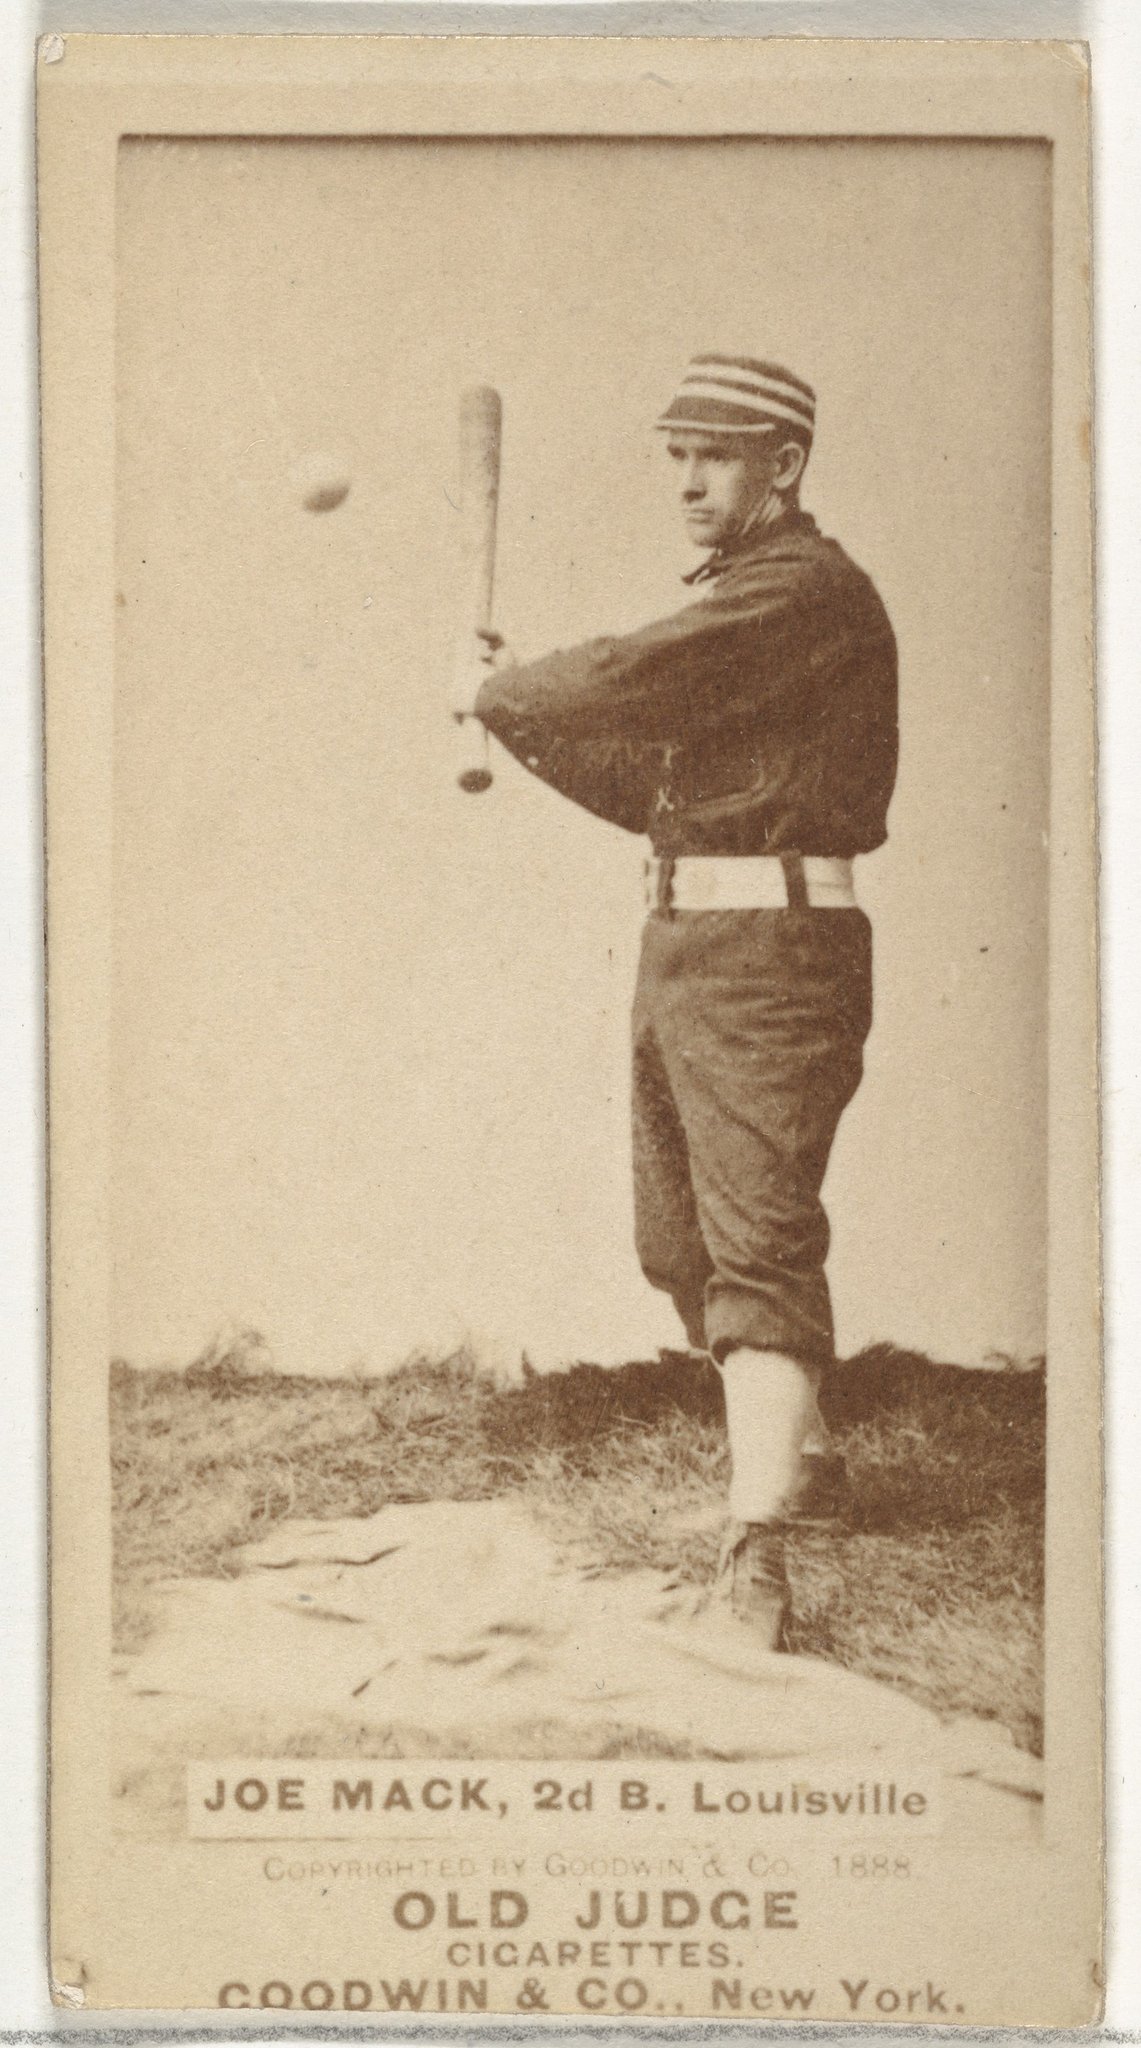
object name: baseball card, photograph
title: Joseph "Reddy" Mack, 2nd Base, Louisville Colonels, from the Old Judge series (N172) for Old Judge Cigarettes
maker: goodwin & company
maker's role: publisher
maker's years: 1850-1950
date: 1888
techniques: albumen silver print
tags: men,portraits,baseball,athletes